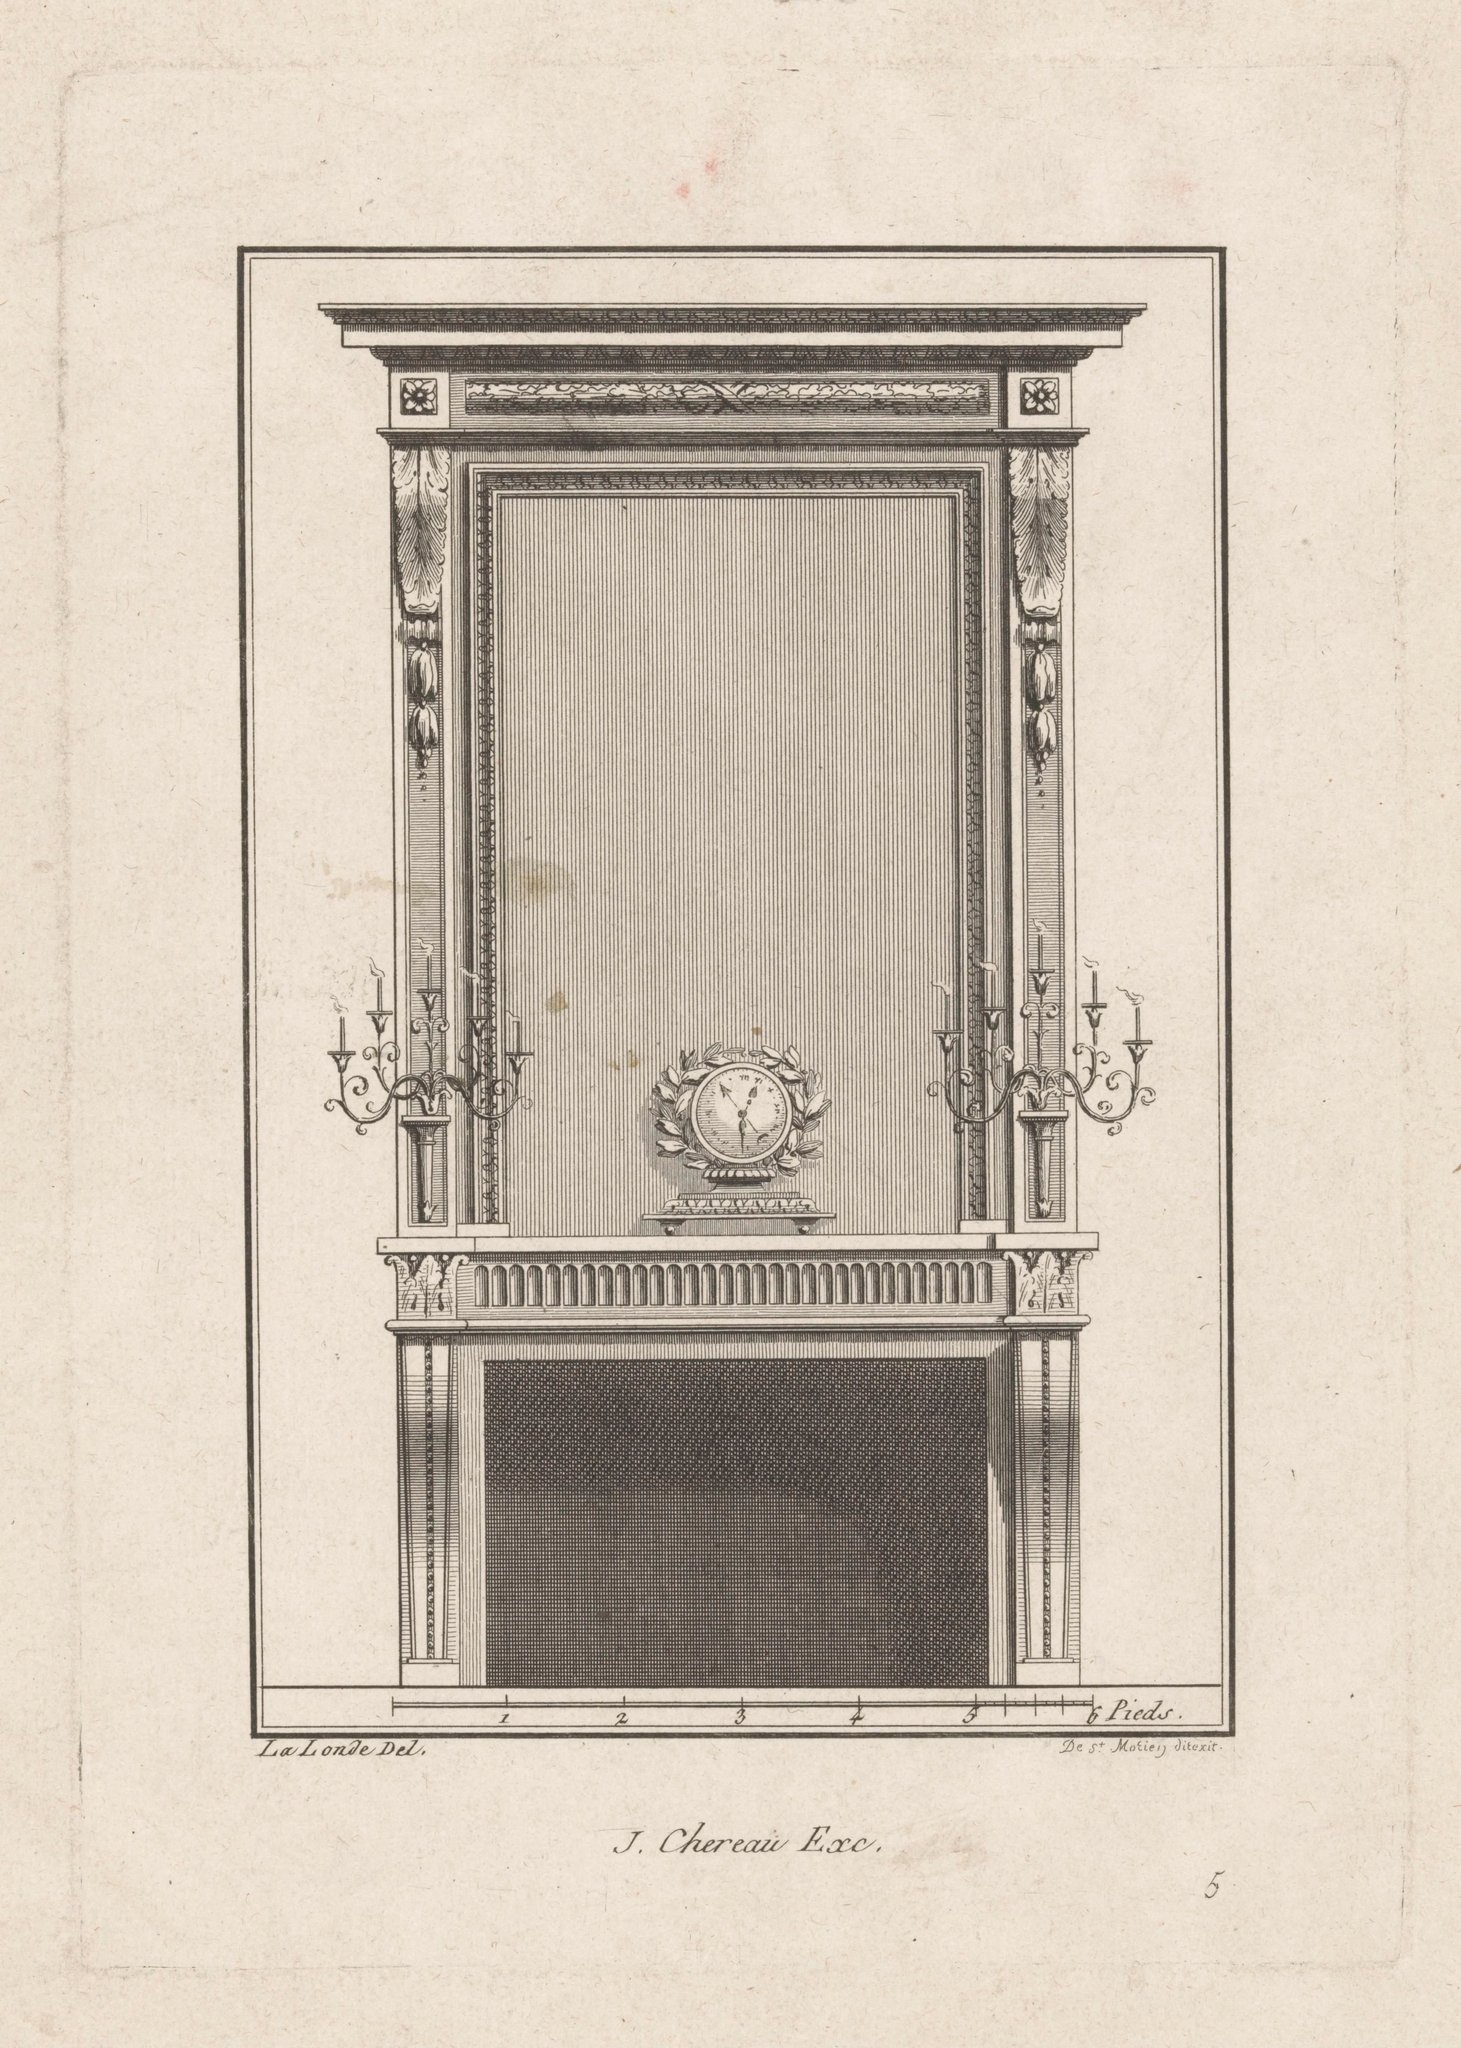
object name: print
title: Différens Ornements de Cheminees et Chambranles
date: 1784-1785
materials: paper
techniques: engraving, etching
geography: paris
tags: chandelier, candelabrum, open hearth, fire-place, clock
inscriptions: collector's mark: Lugt 2228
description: Een geornamenteerde schouw met bladmotieven, een klok en twee vijfarmige kandelaars.